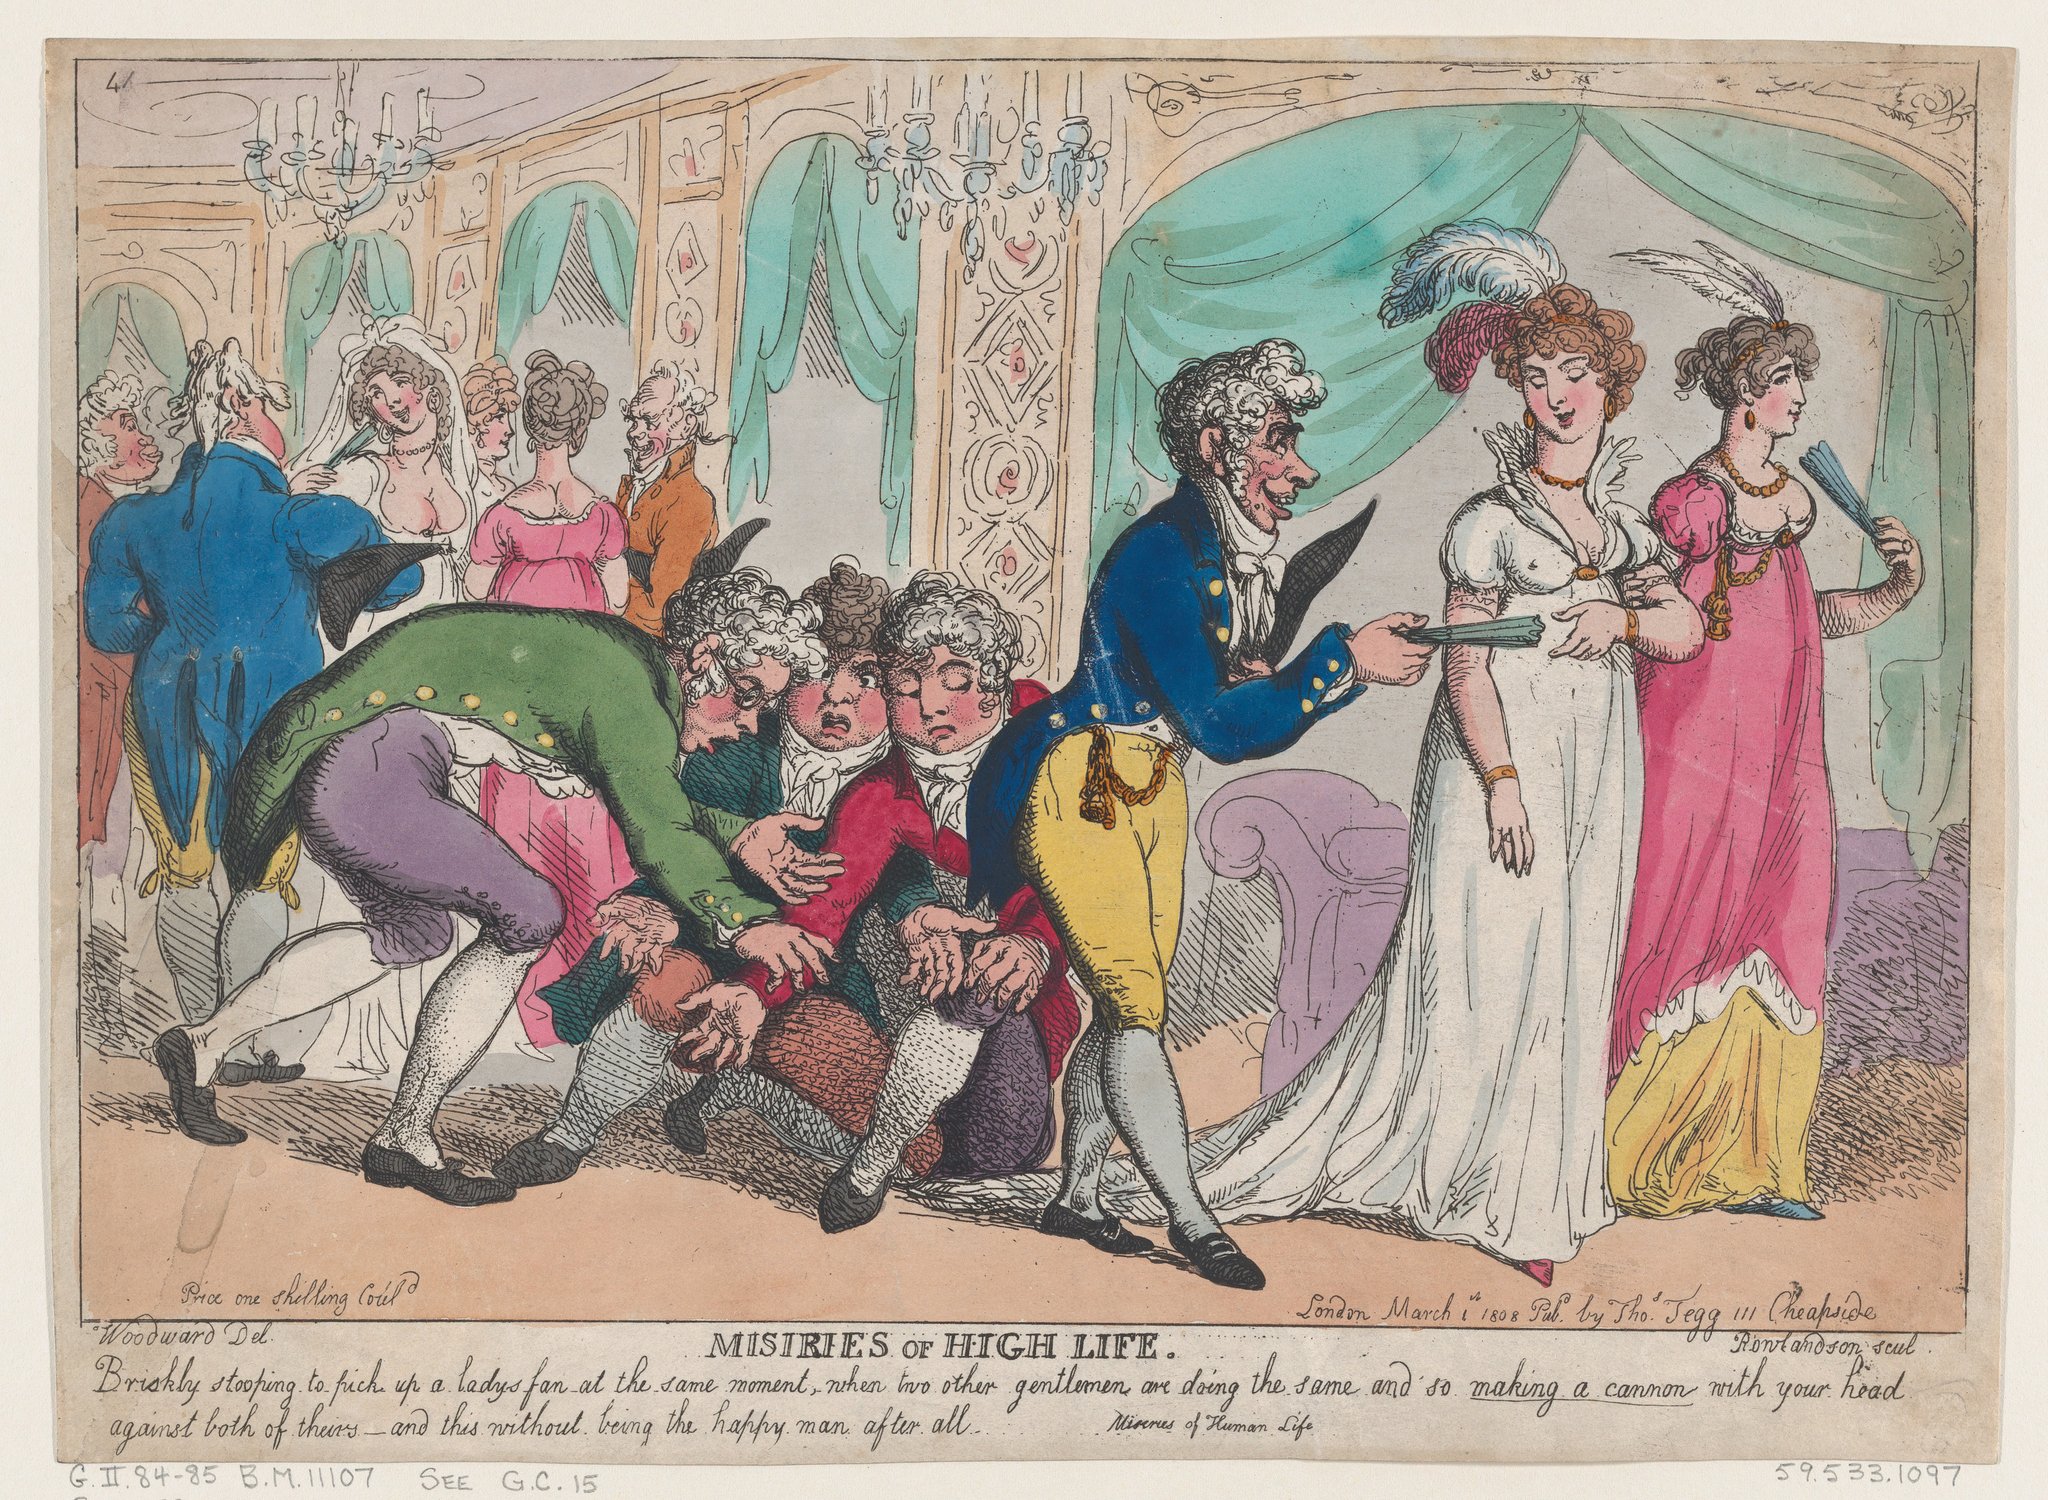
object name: print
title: Miseries of High Life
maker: thomas rowlandson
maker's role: artist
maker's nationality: british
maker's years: 1757-1827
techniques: etching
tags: men,women